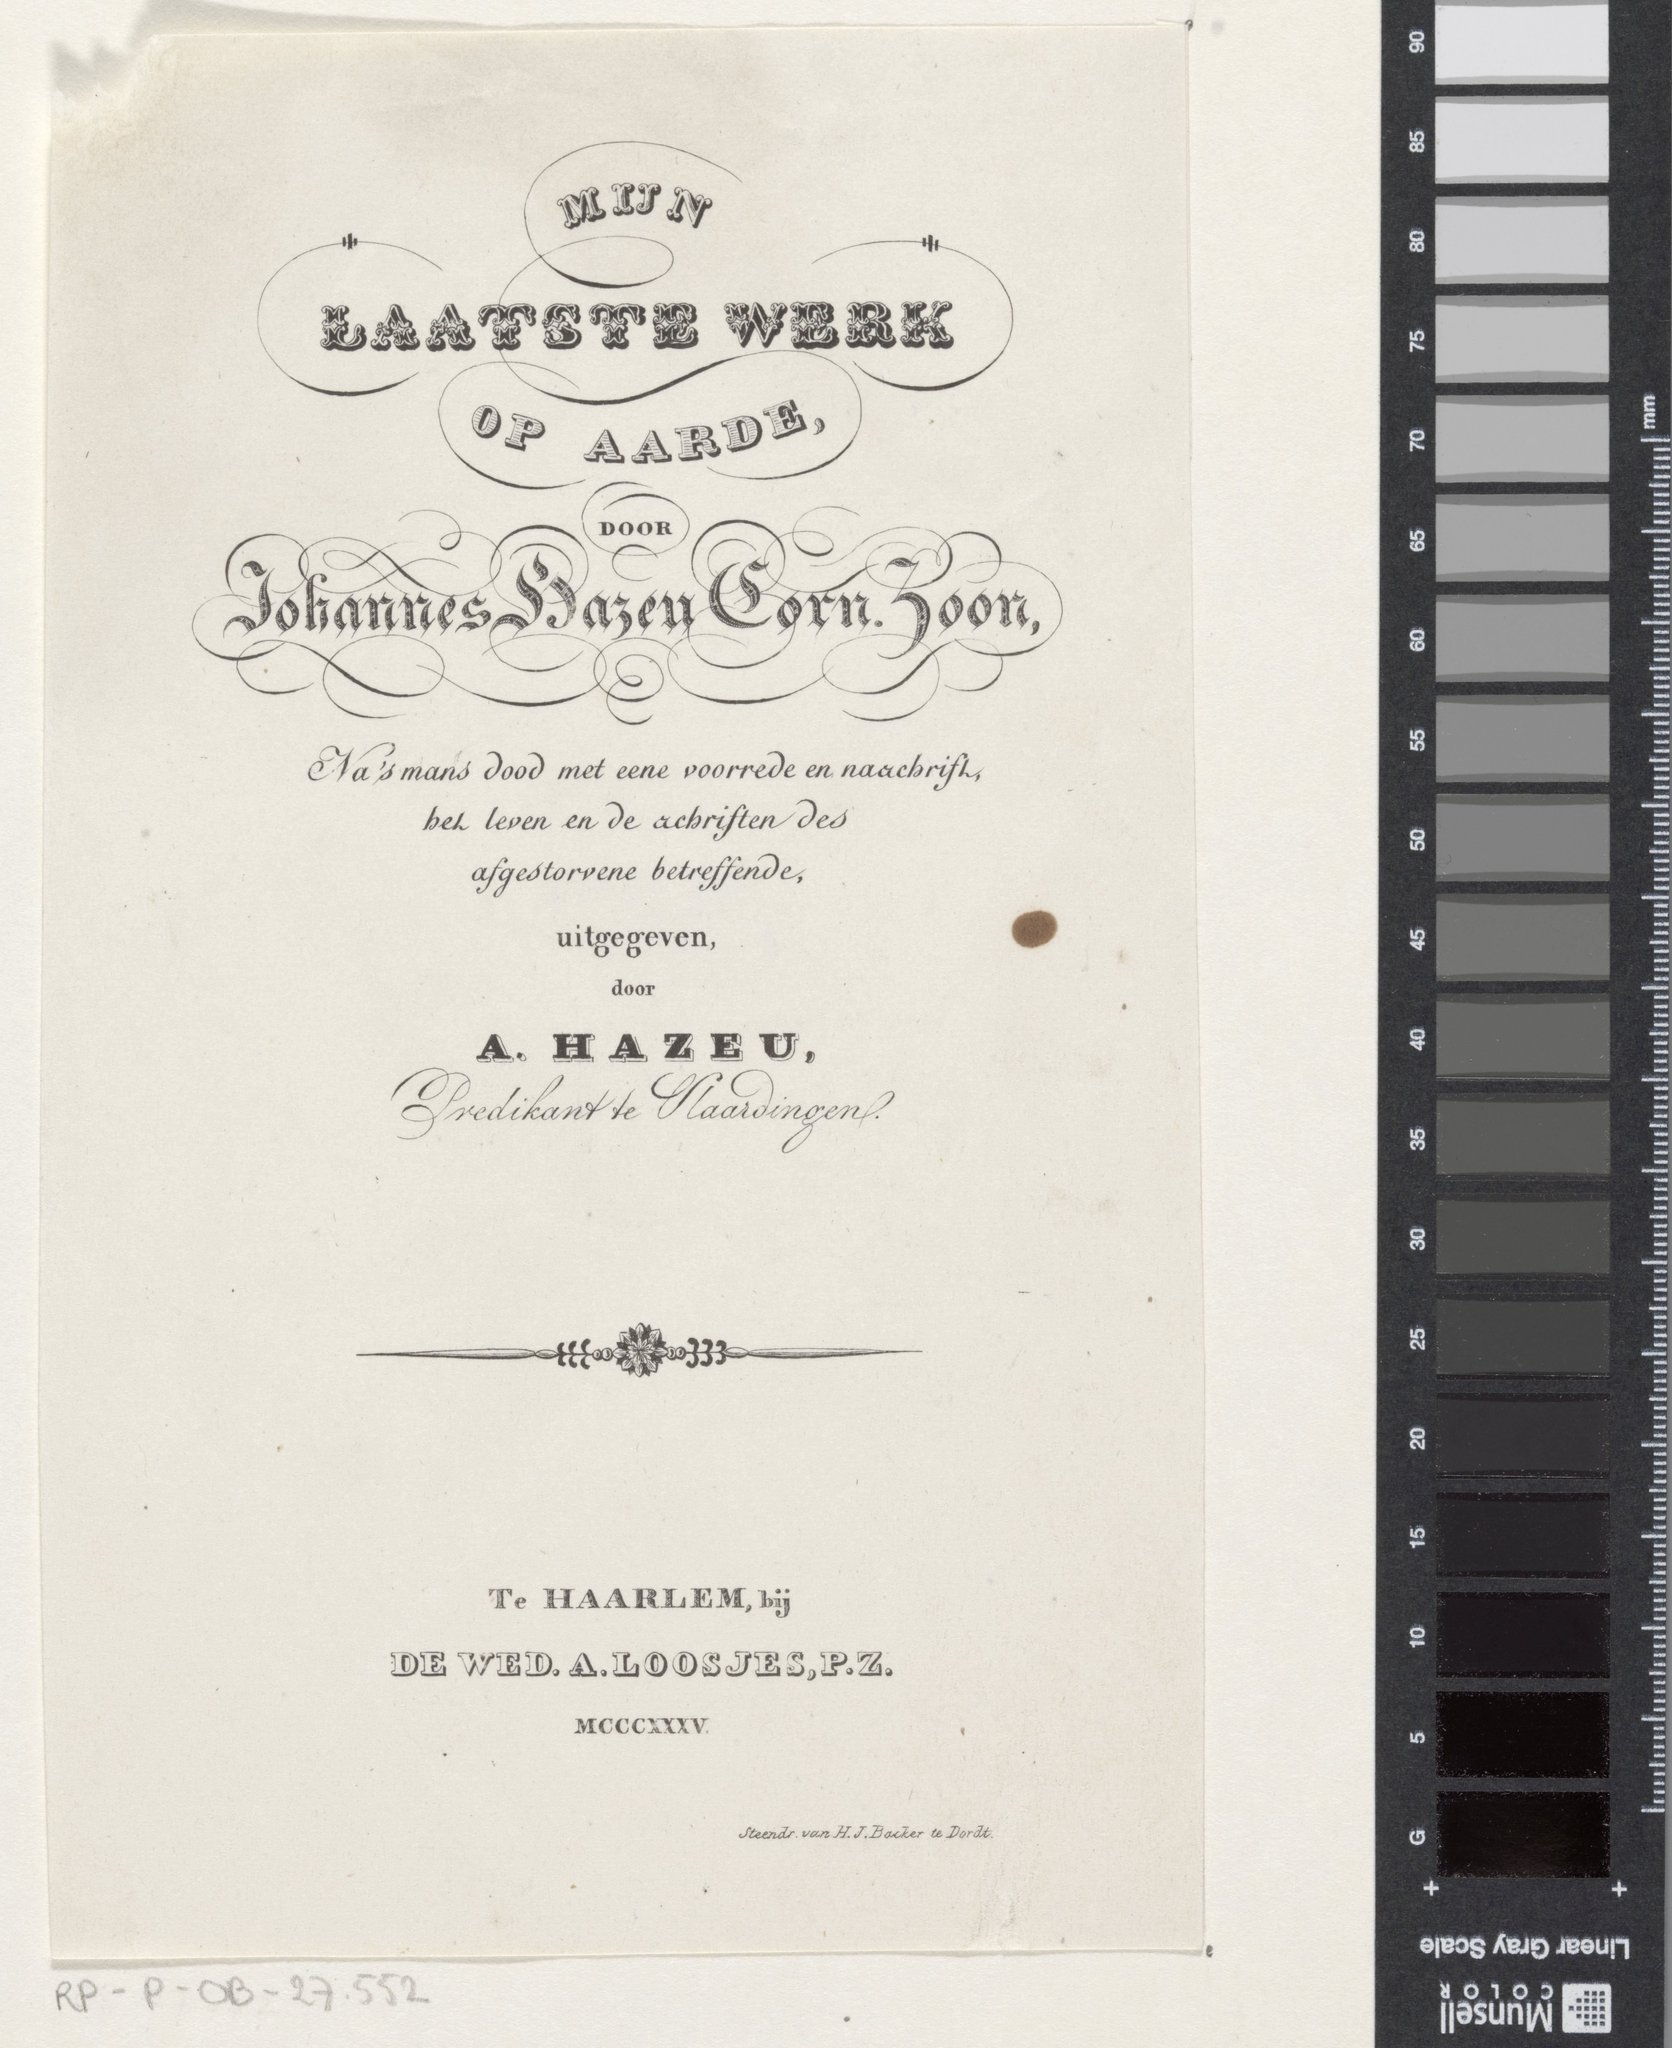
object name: titelblad, titelpagina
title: Titelpagina voor: Johannes Hazen Corneliszoon, Mijn laatste werk op aarde, 1835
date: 1835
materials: paper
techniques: lithograph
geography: haarlem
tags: haarlem, johannes hazeu cornelisz.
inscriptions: collector's mark: Lugt 2228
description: Titelpagina voor Hazeu, Johannes Cornelisz. Mijn laatste werk op aarde. Haarlem: De Wed. A. Loosjes, P.Z. 1835